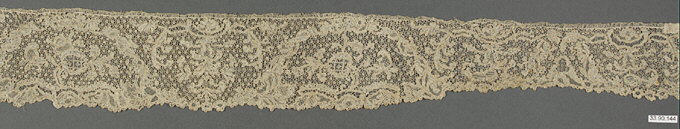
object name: edging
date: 1701-1733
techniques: lace